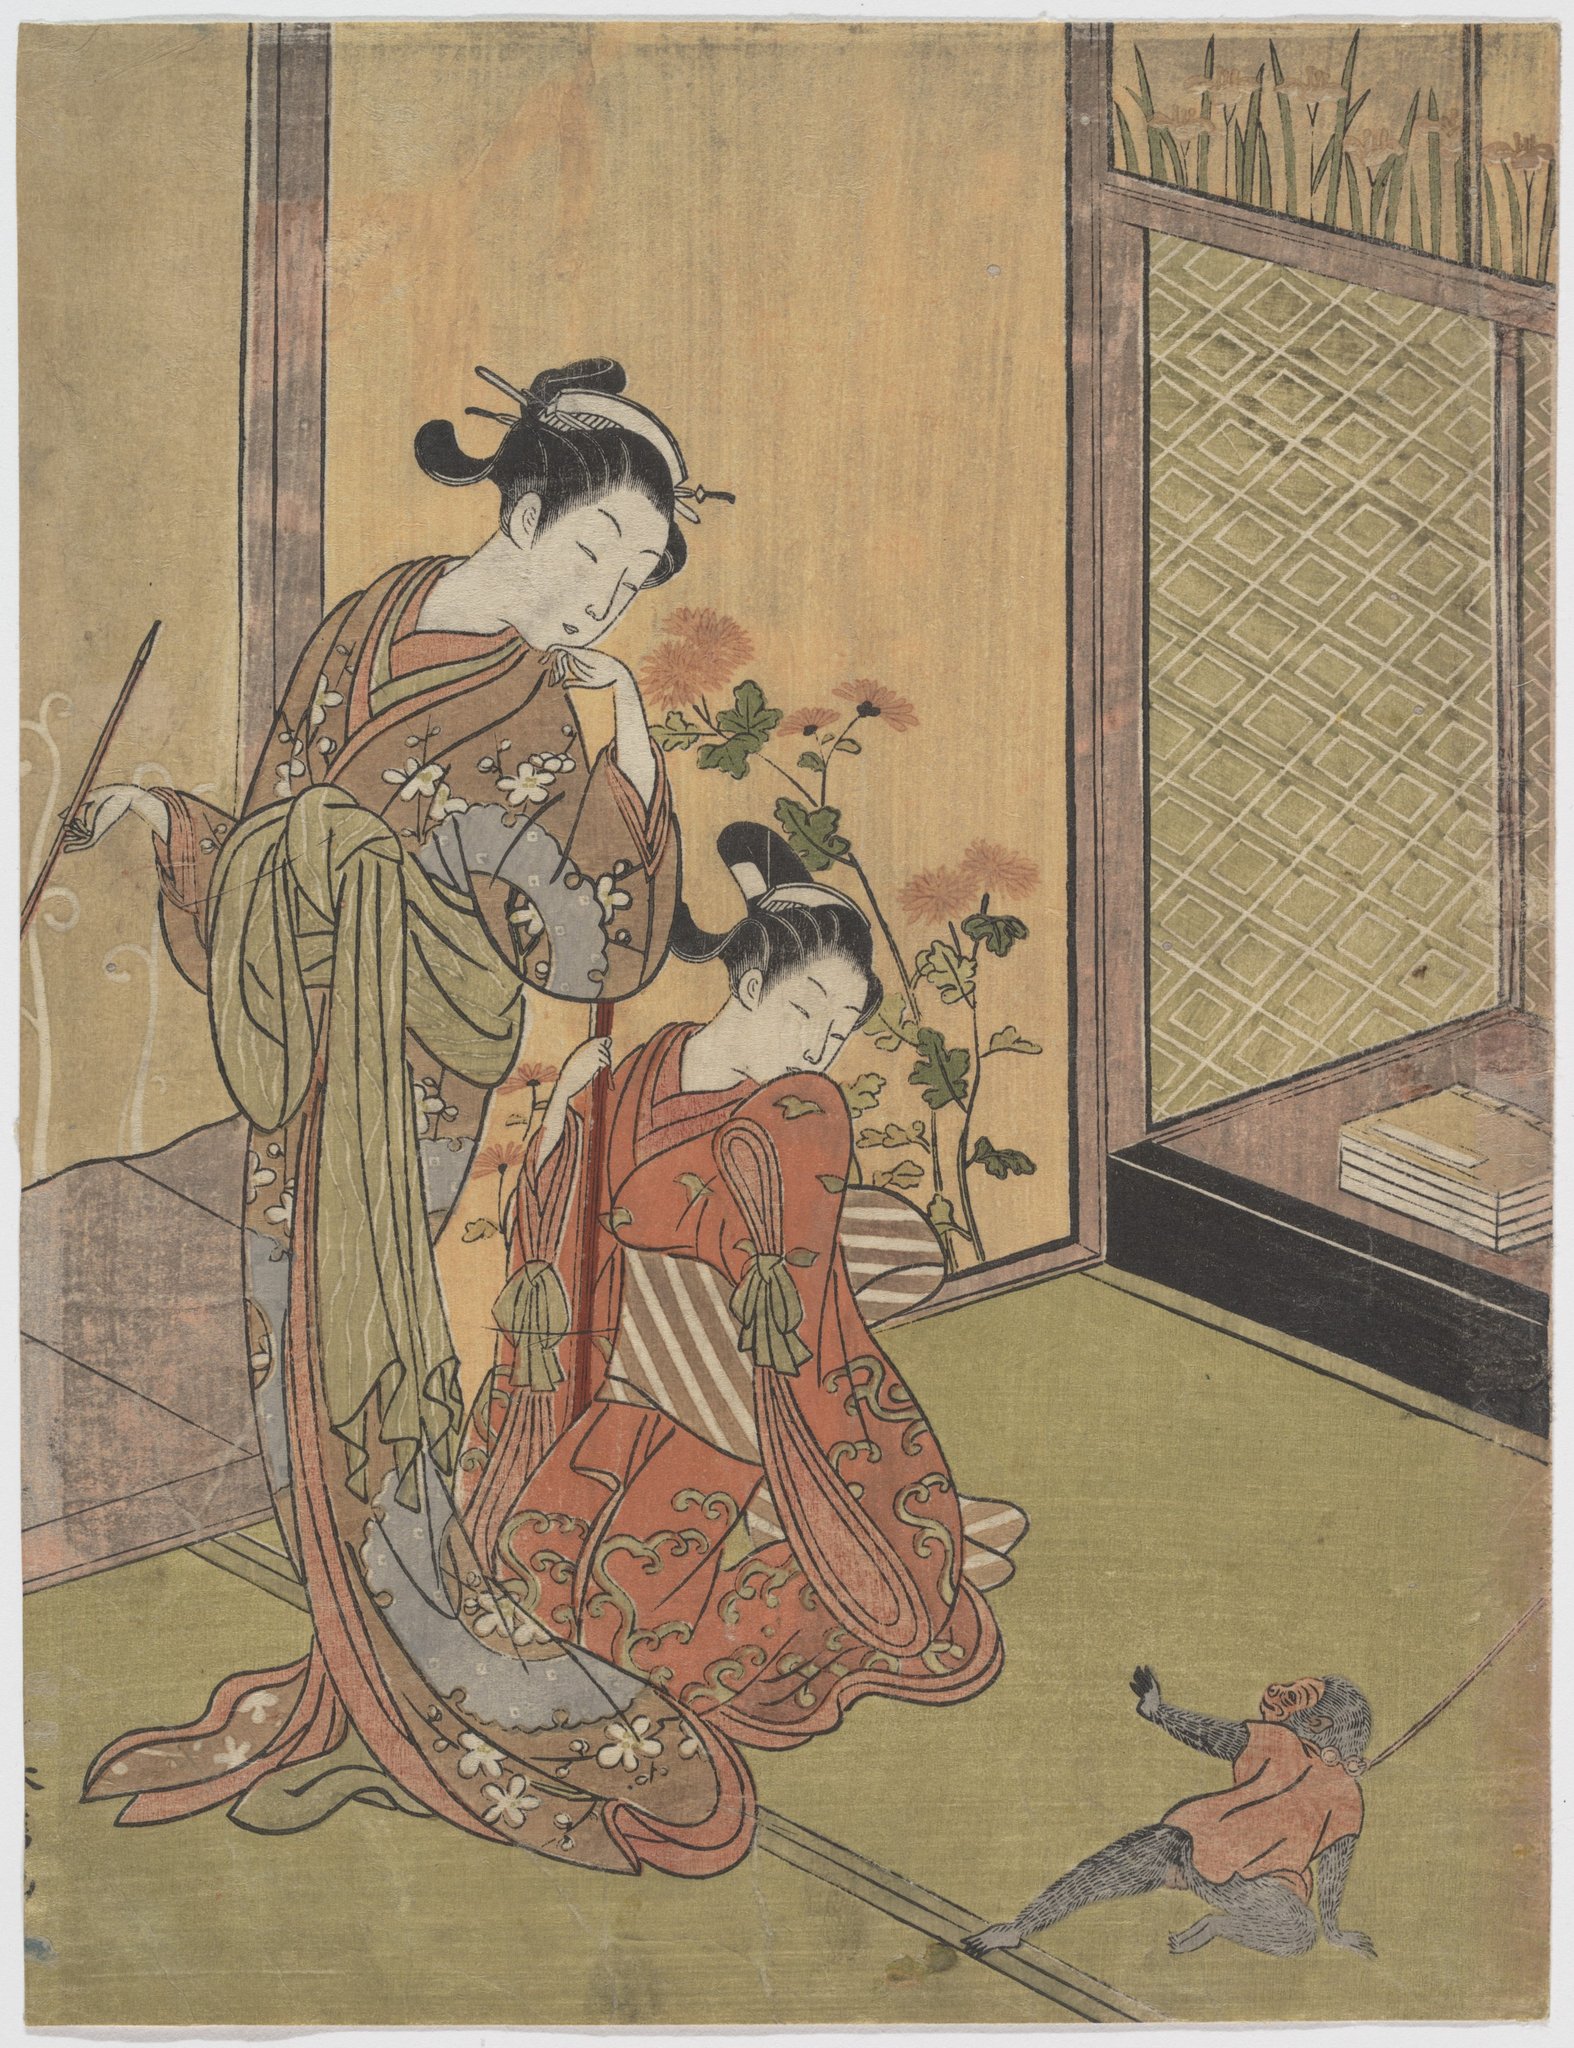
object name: print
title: Two Girls Looking at a Monkey on a Leash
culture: japanese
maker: suzuki harunobu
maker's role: artist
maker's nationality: japanese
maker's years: 1725-1770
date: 1725-1770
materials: ink, paper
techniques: woodblock print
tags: girls,monkeys